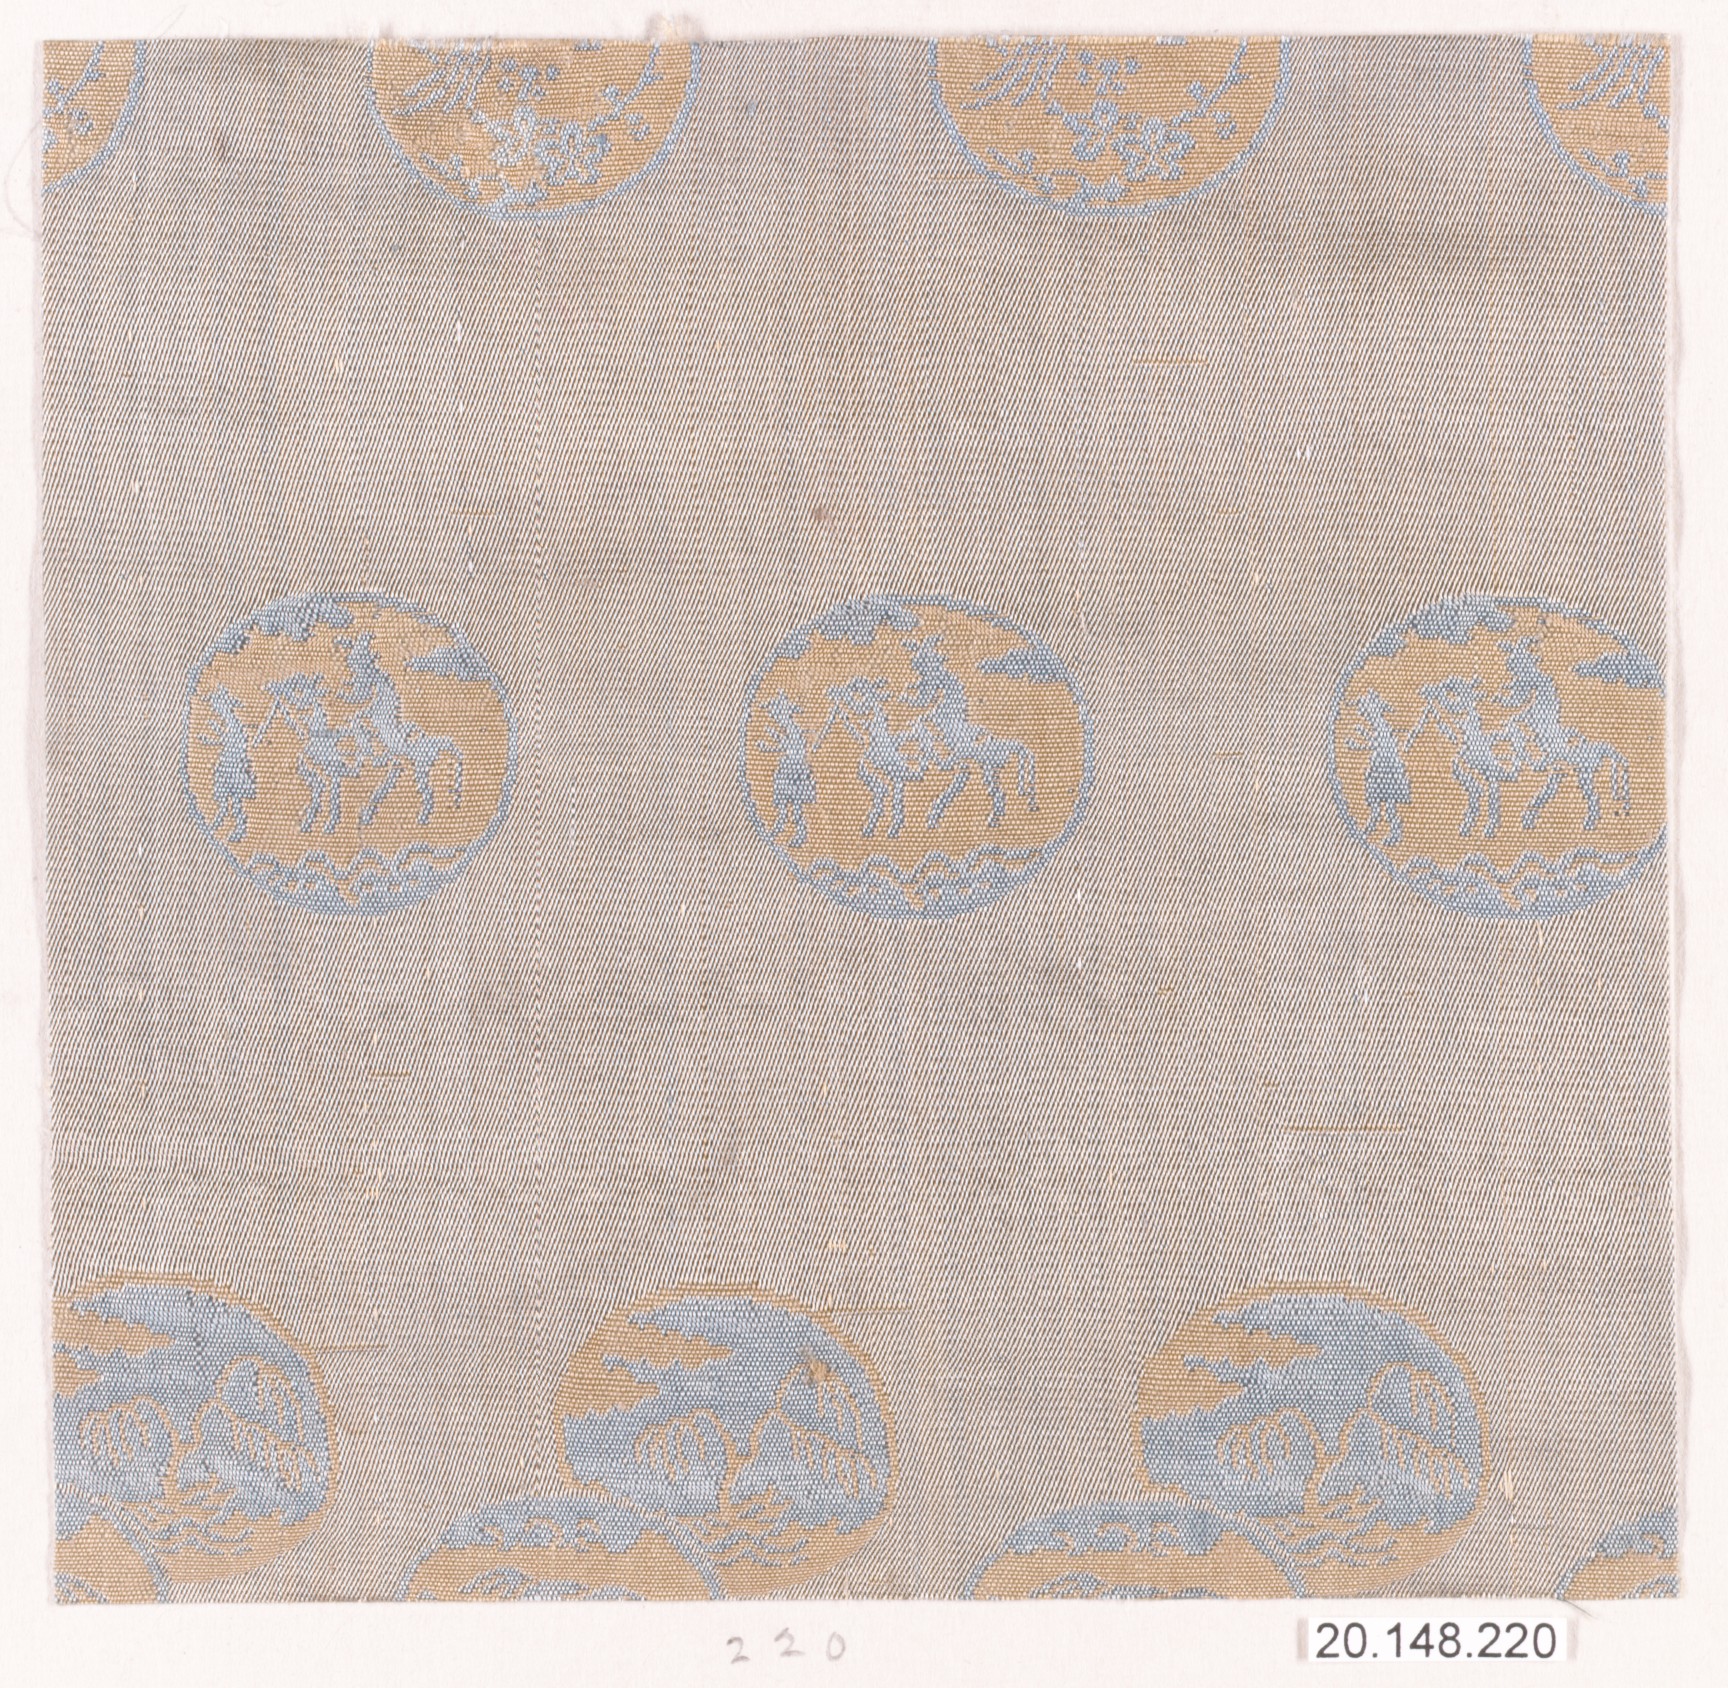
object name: piece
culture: japanese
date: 1701-1800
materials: silk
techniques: compound weave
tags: human figures,animals